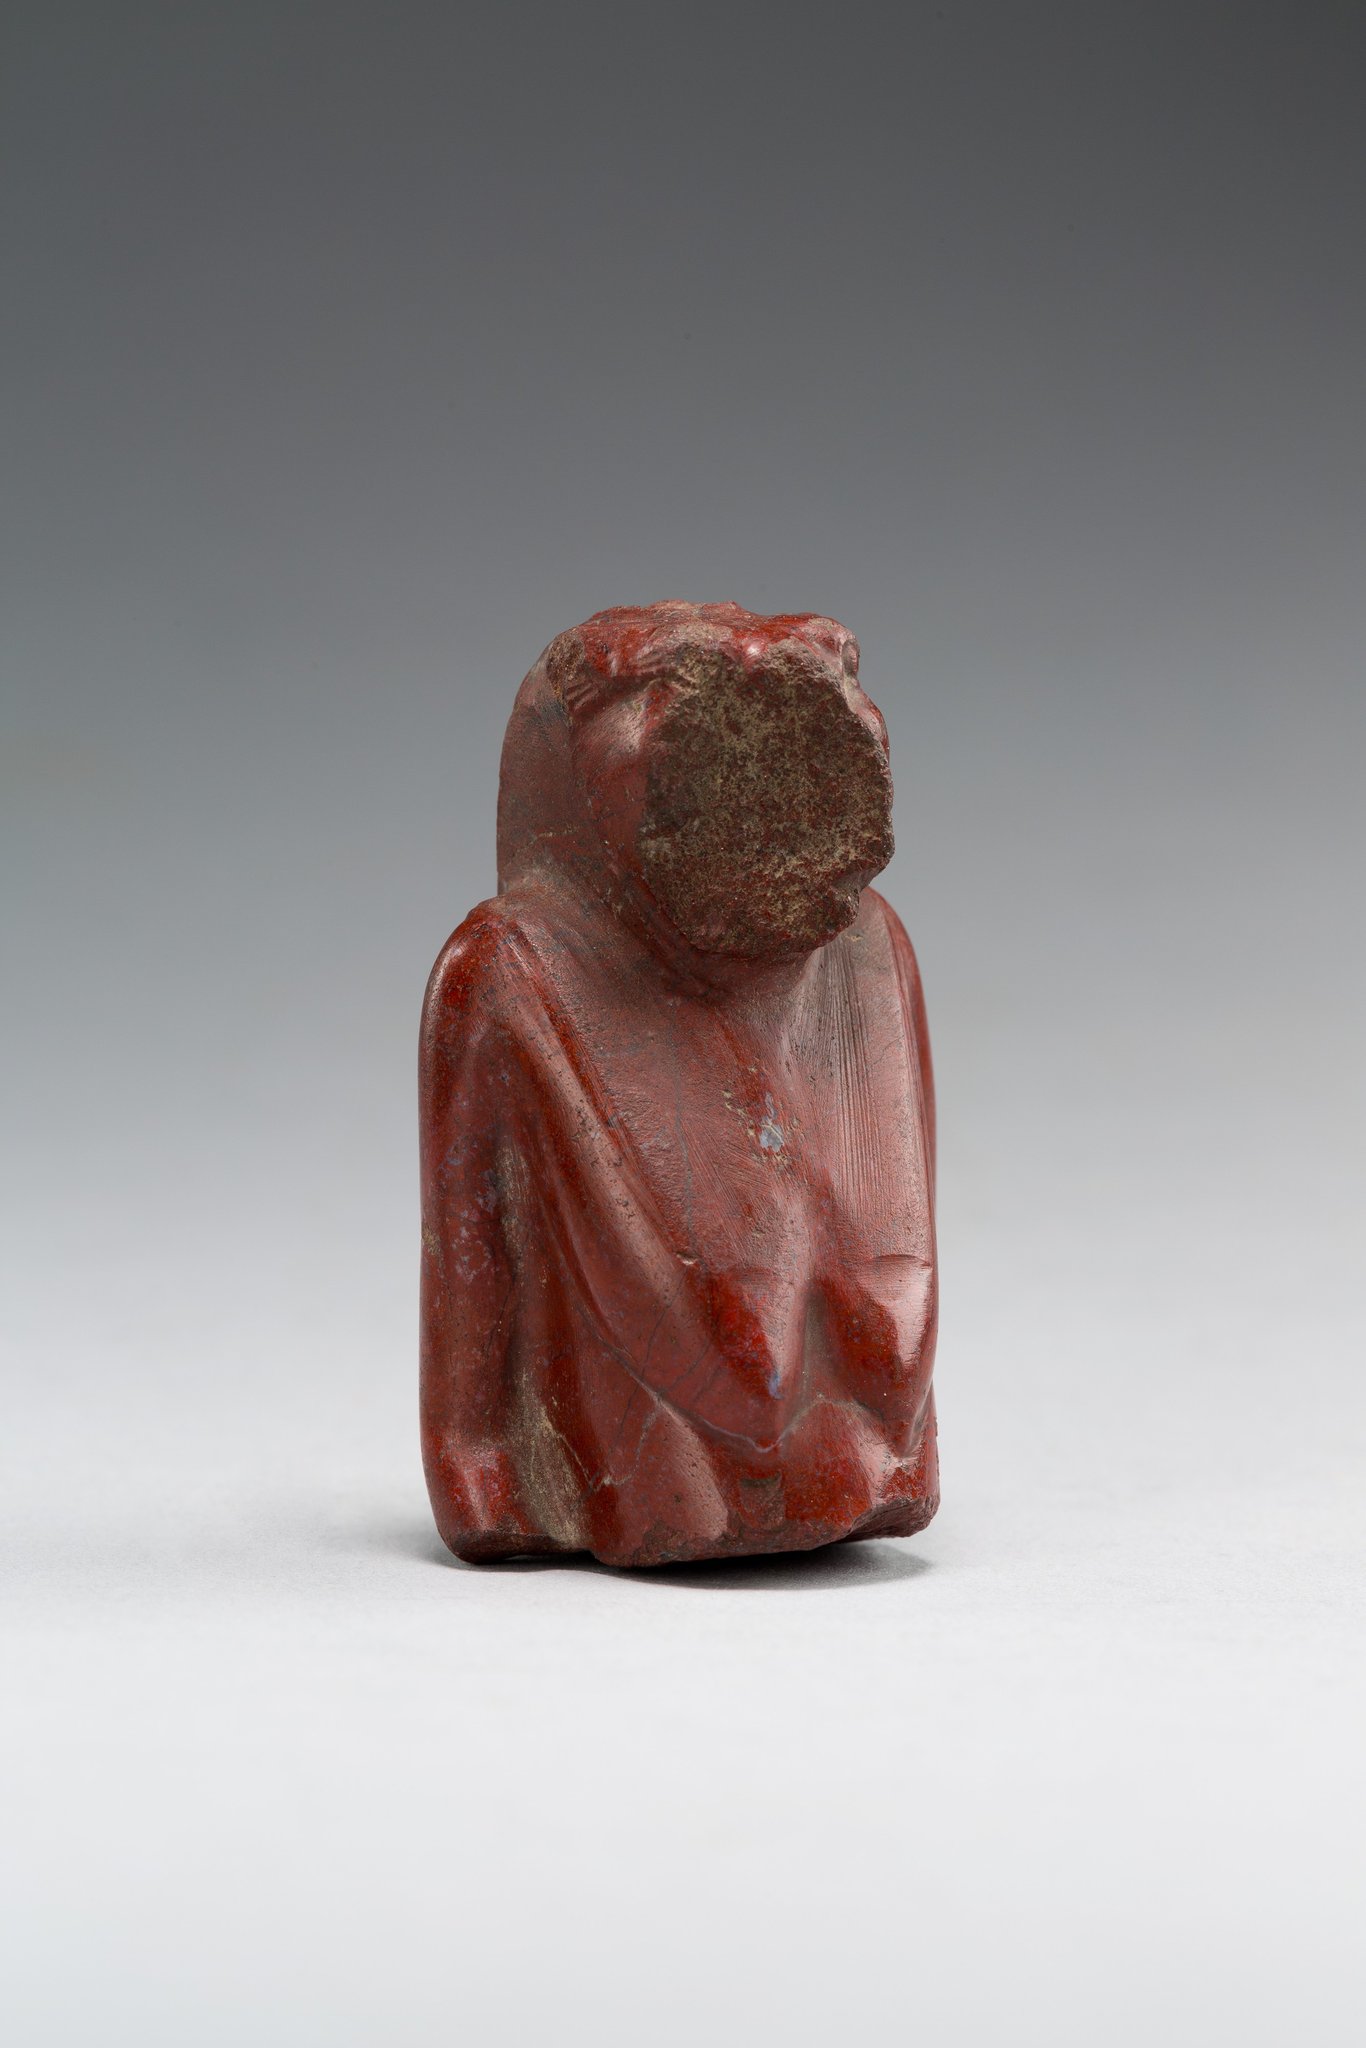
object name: statuette, taweret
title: Taweret statuette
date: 664-332 BCE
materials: jasper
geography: egypt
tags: taweret